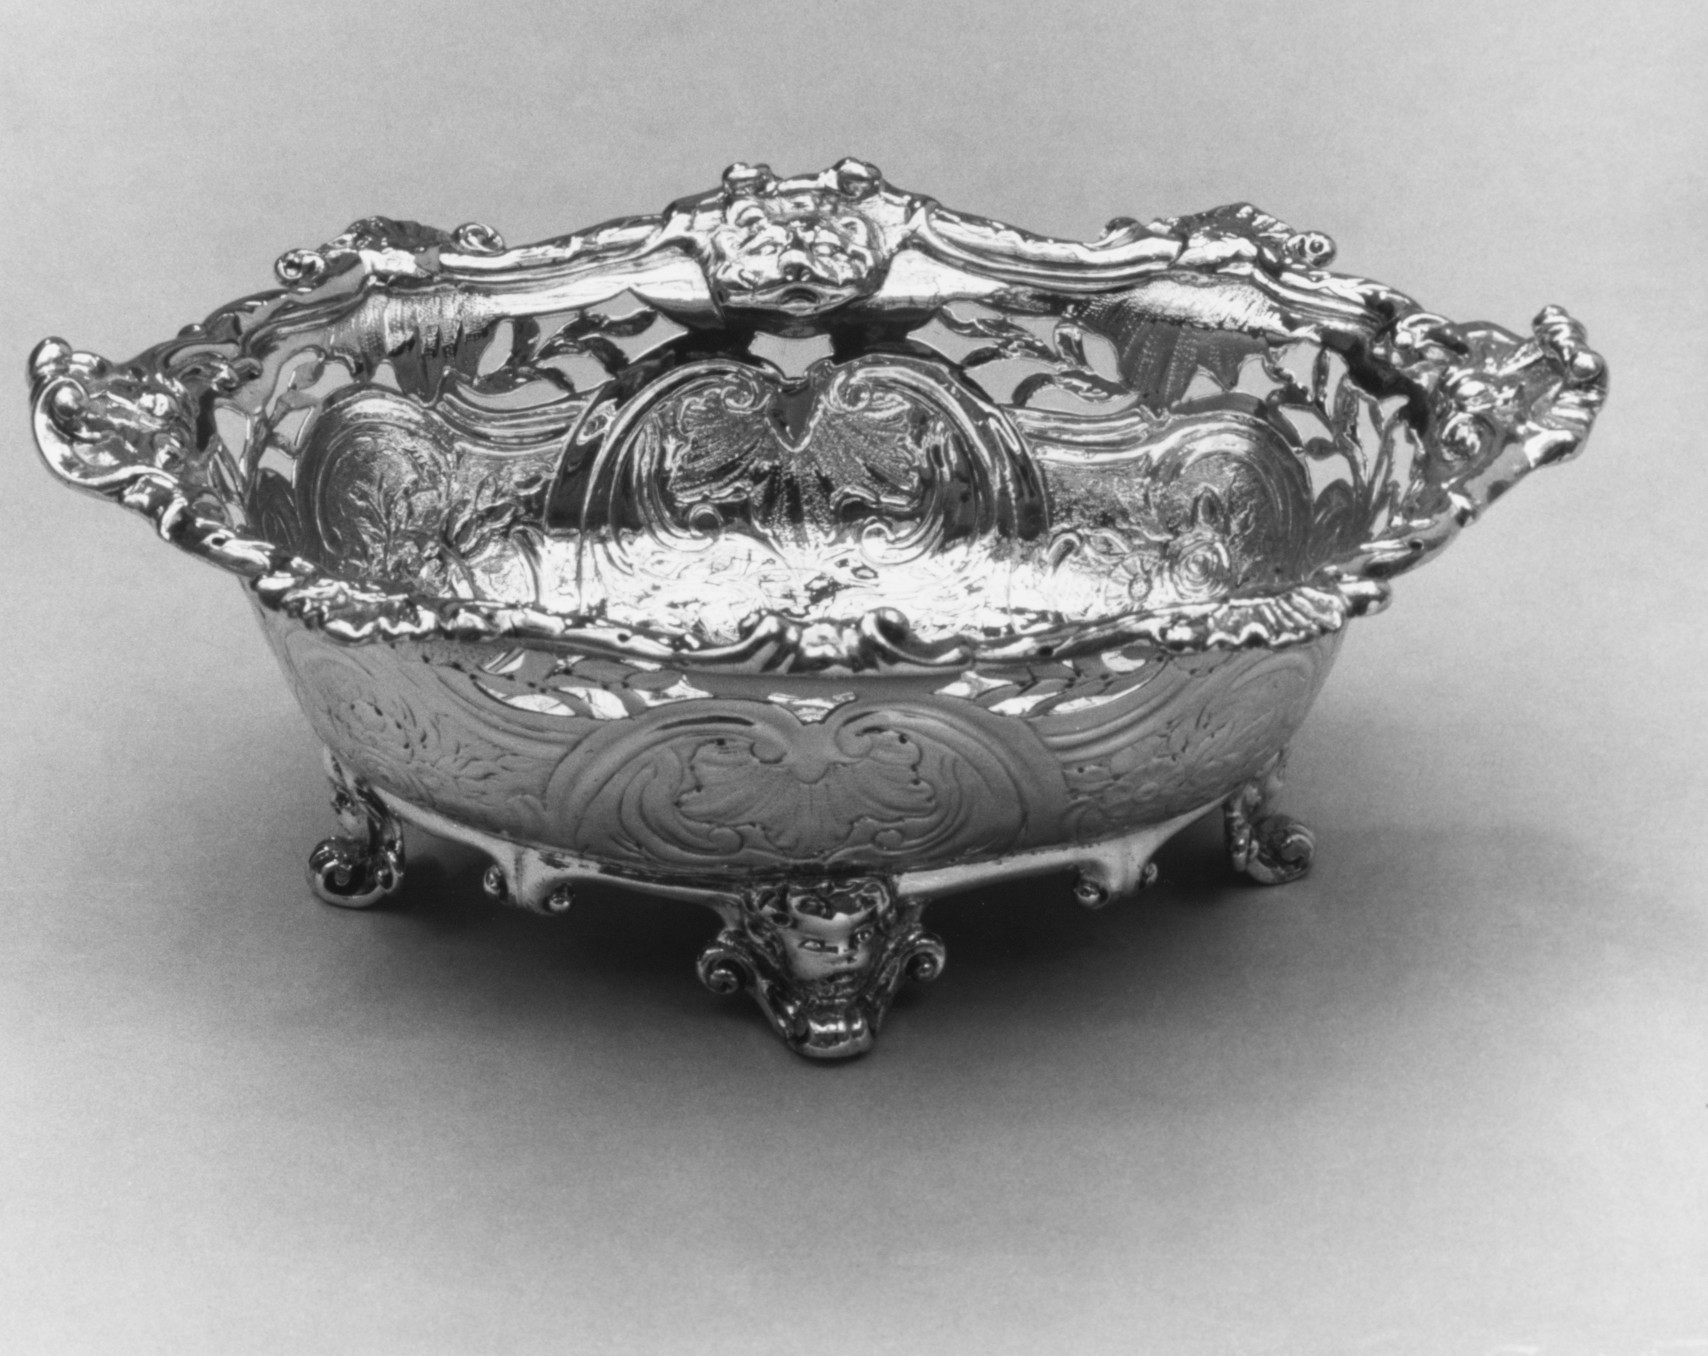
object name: dish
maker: paul de lamerie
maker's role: maker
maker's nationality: british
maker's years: 1688-1751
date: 1742-1743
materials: silver